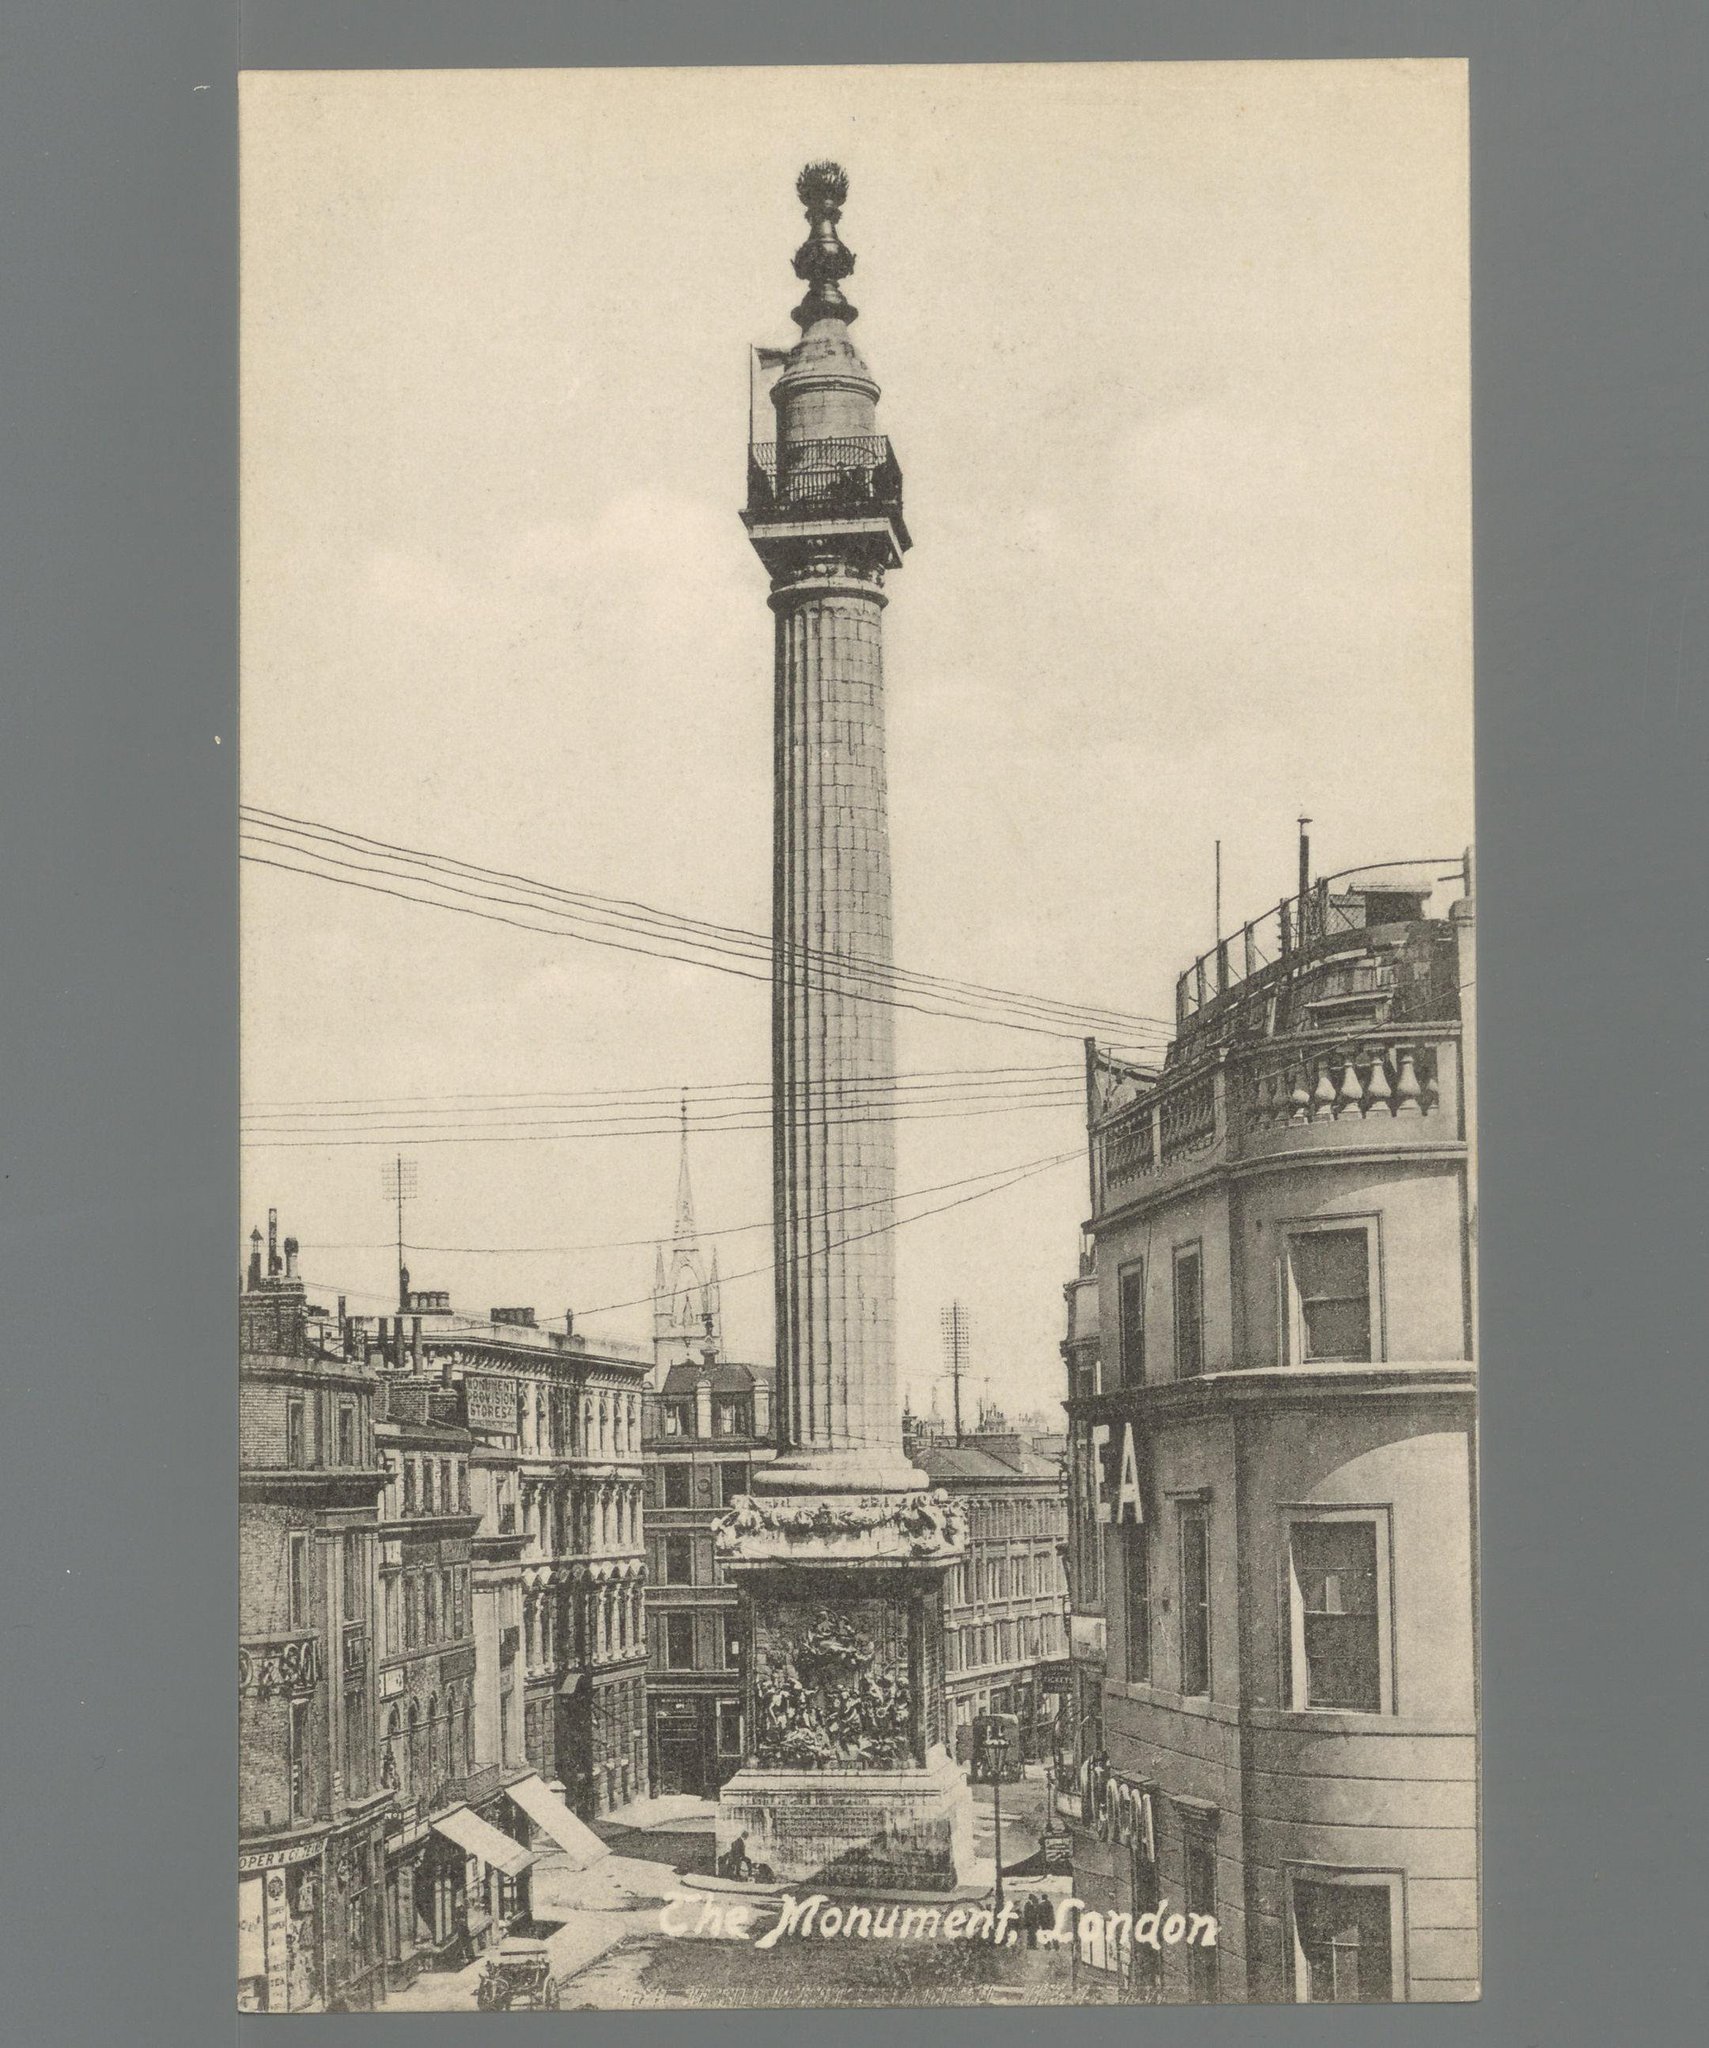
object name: ansichtkaart, prentbriefkaart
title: The Monument, London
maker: Anonymous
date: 1902-1930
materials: cardboard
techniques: photograph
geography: london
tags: monument, statue, street